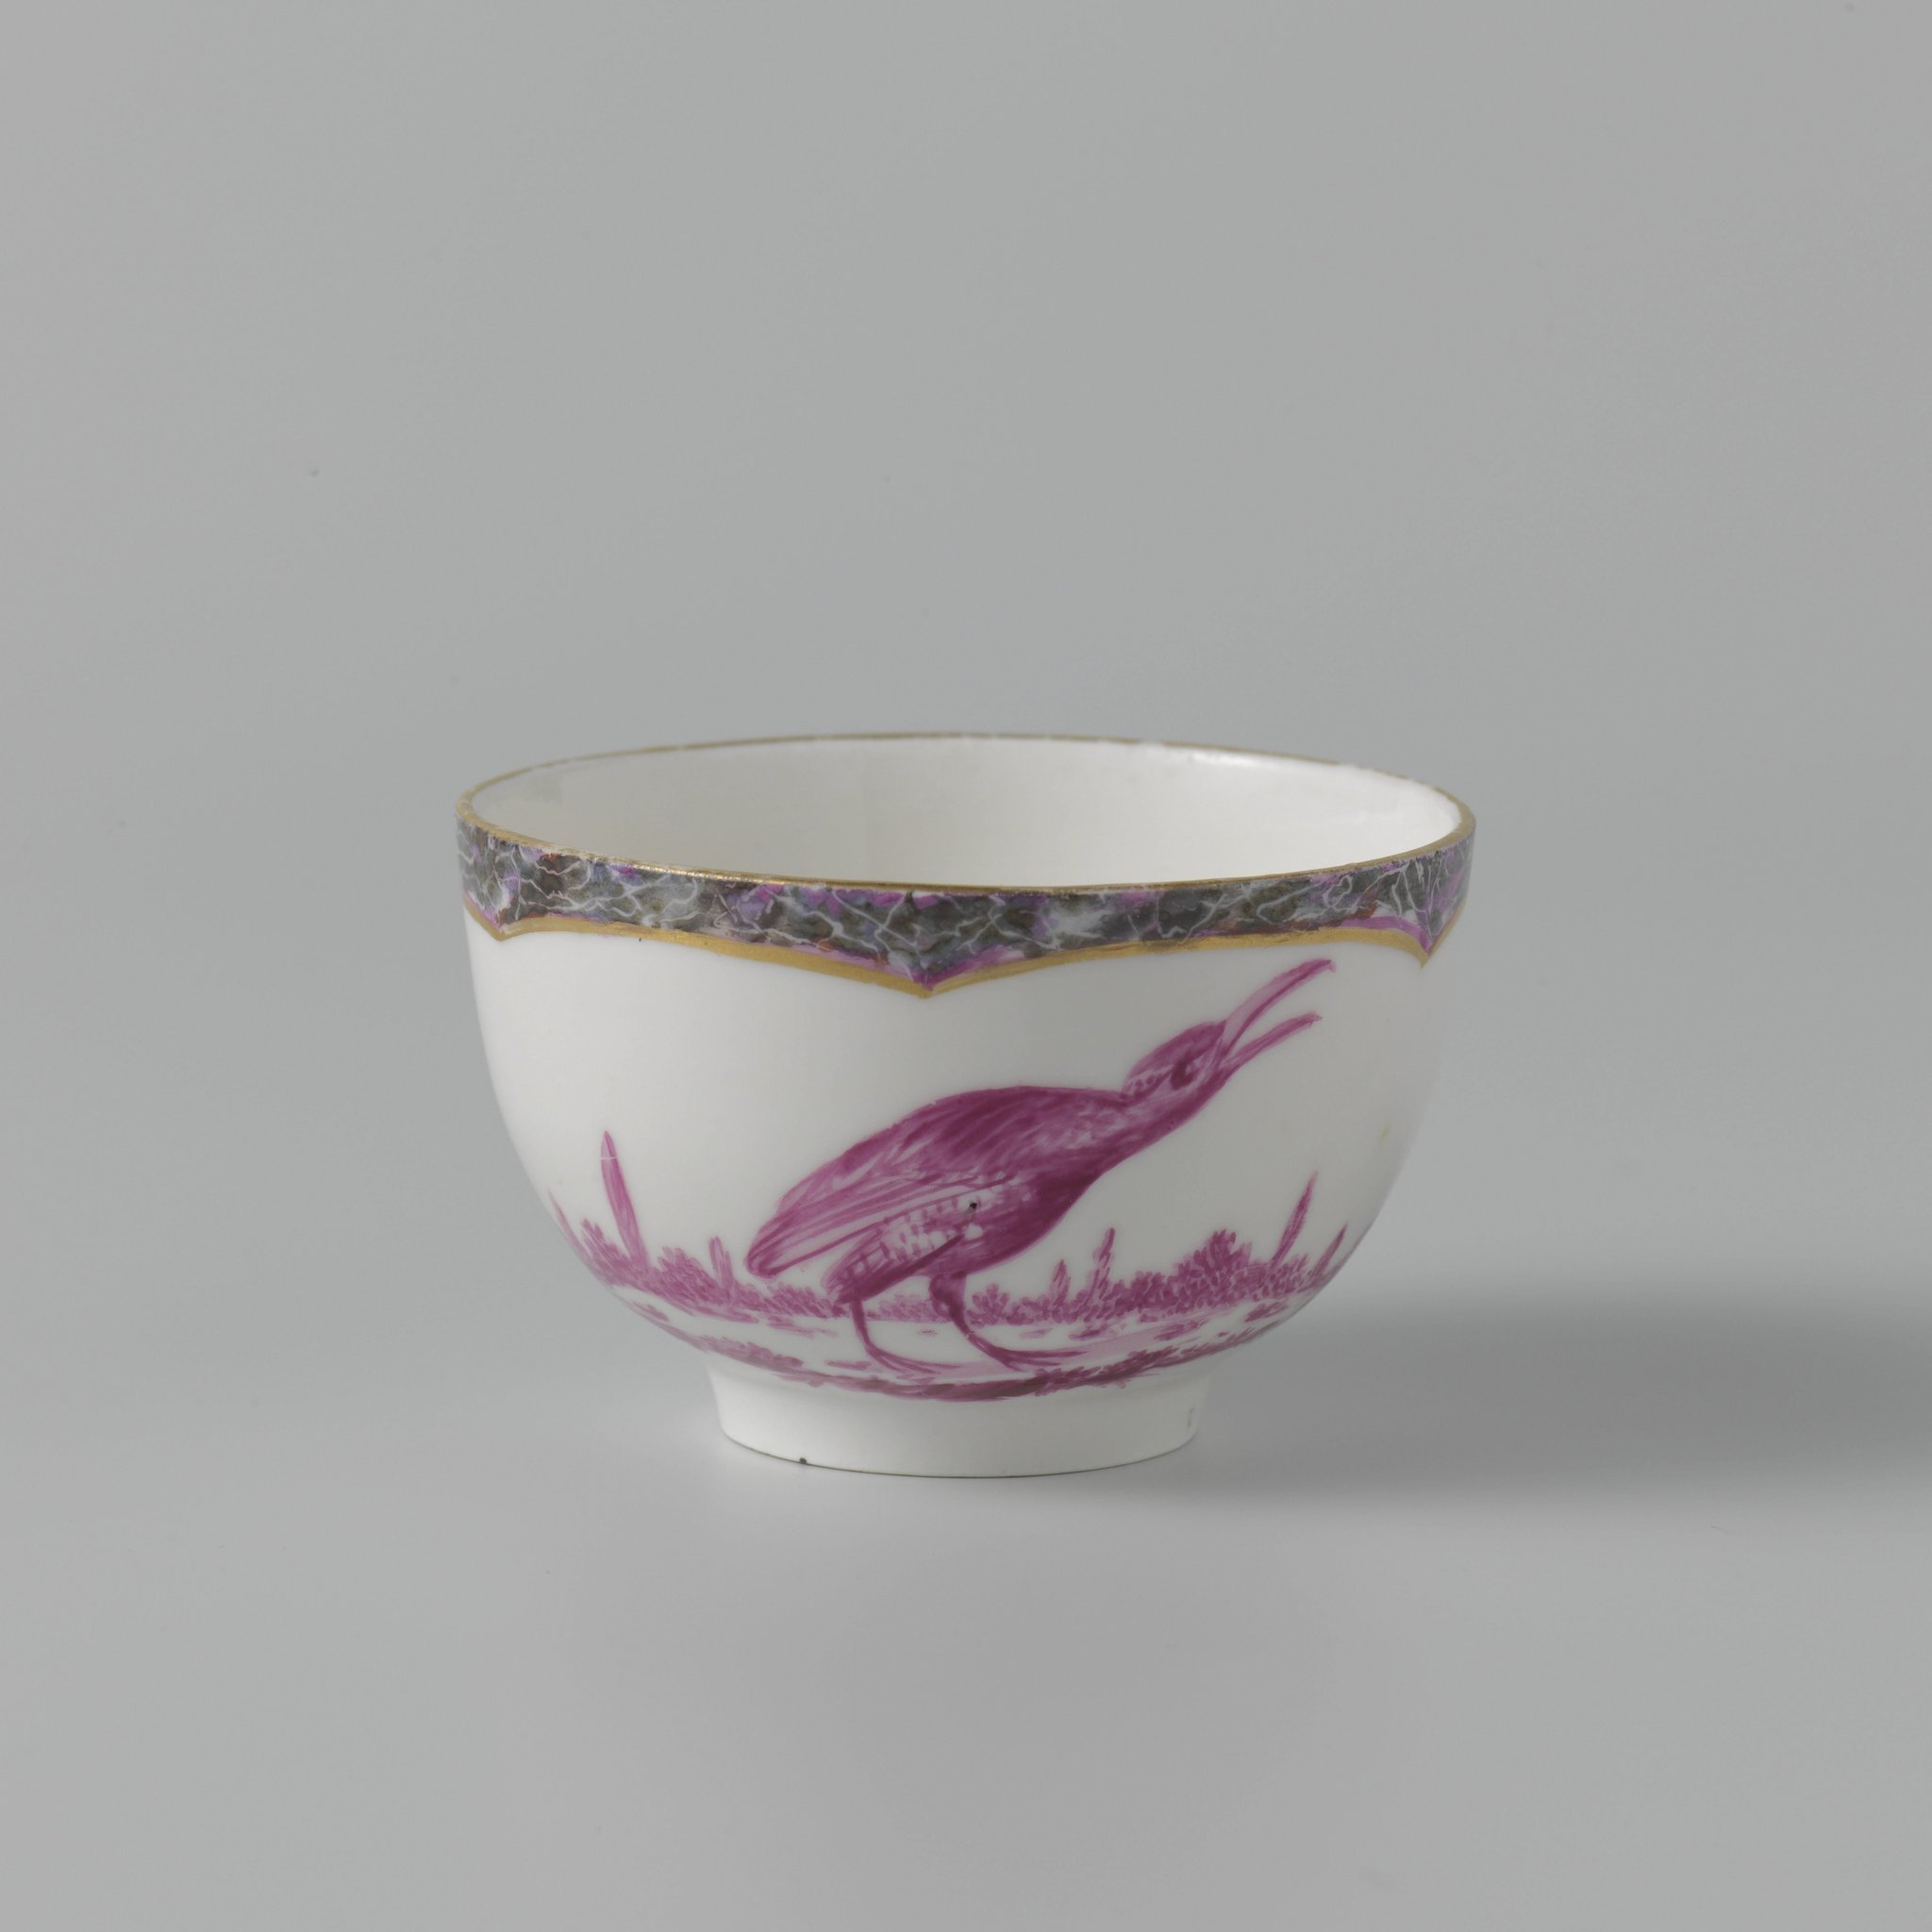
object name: cup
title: Cup and saucer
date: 1778-1782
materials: porcelain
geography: loosdrecht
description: Manufactuur Oud-Loosdrecht Loosdrecht, c. 1778–1782 hard-paste porcelain